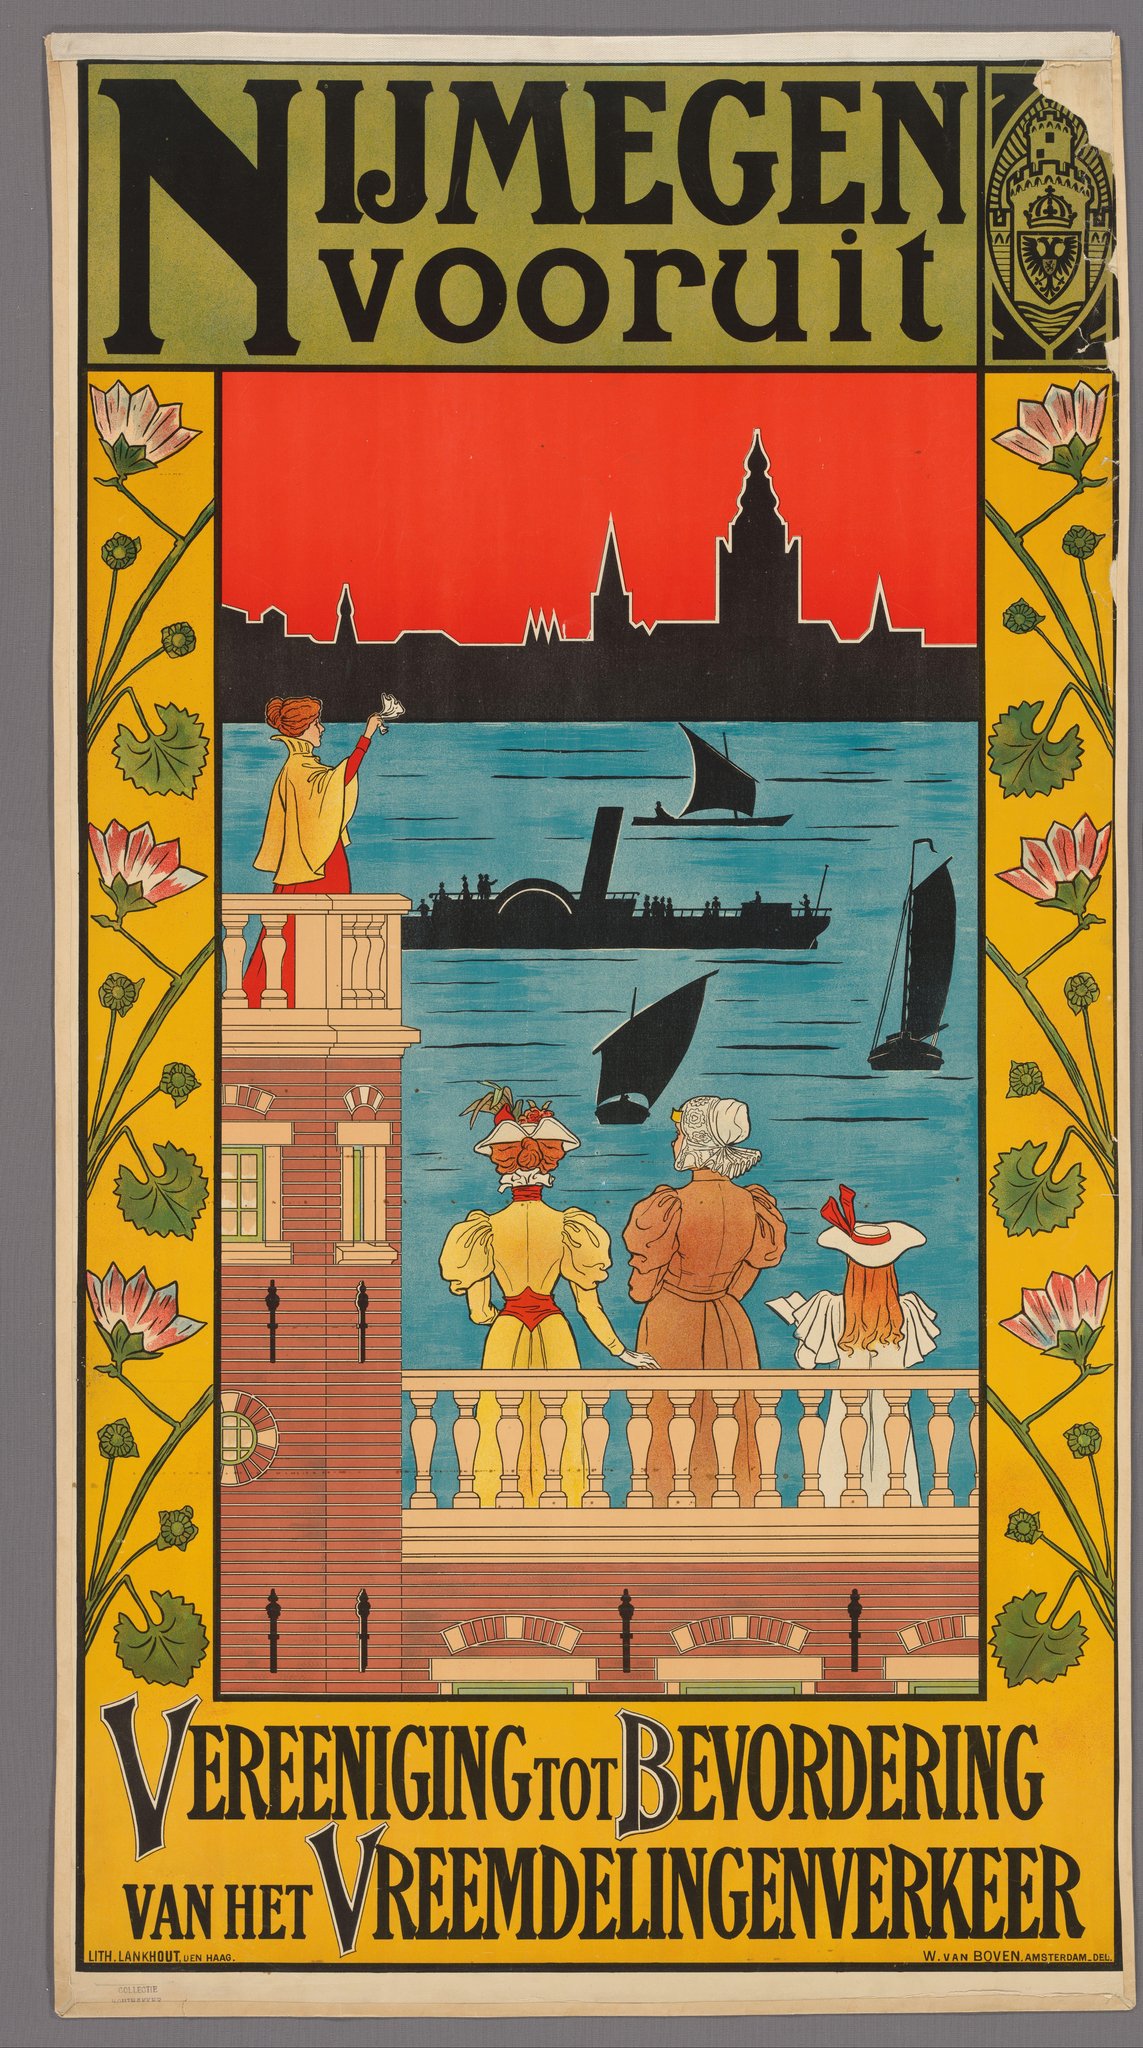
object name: poster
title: Nijmegen vooruit. Vereeniging tot Bevordering van het Vreemdelingenverkeer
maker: henri lankhout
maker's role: draughtsman, printer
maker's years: 1874-1938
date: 1900-1910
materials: paper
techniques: lithograph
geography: the hague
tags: city-view in general; 'veduta', tourism, river, nijmegen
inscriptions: collector's mark: Lugt 2166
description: Met vrouwen die uitkijken over de Waal met boten.